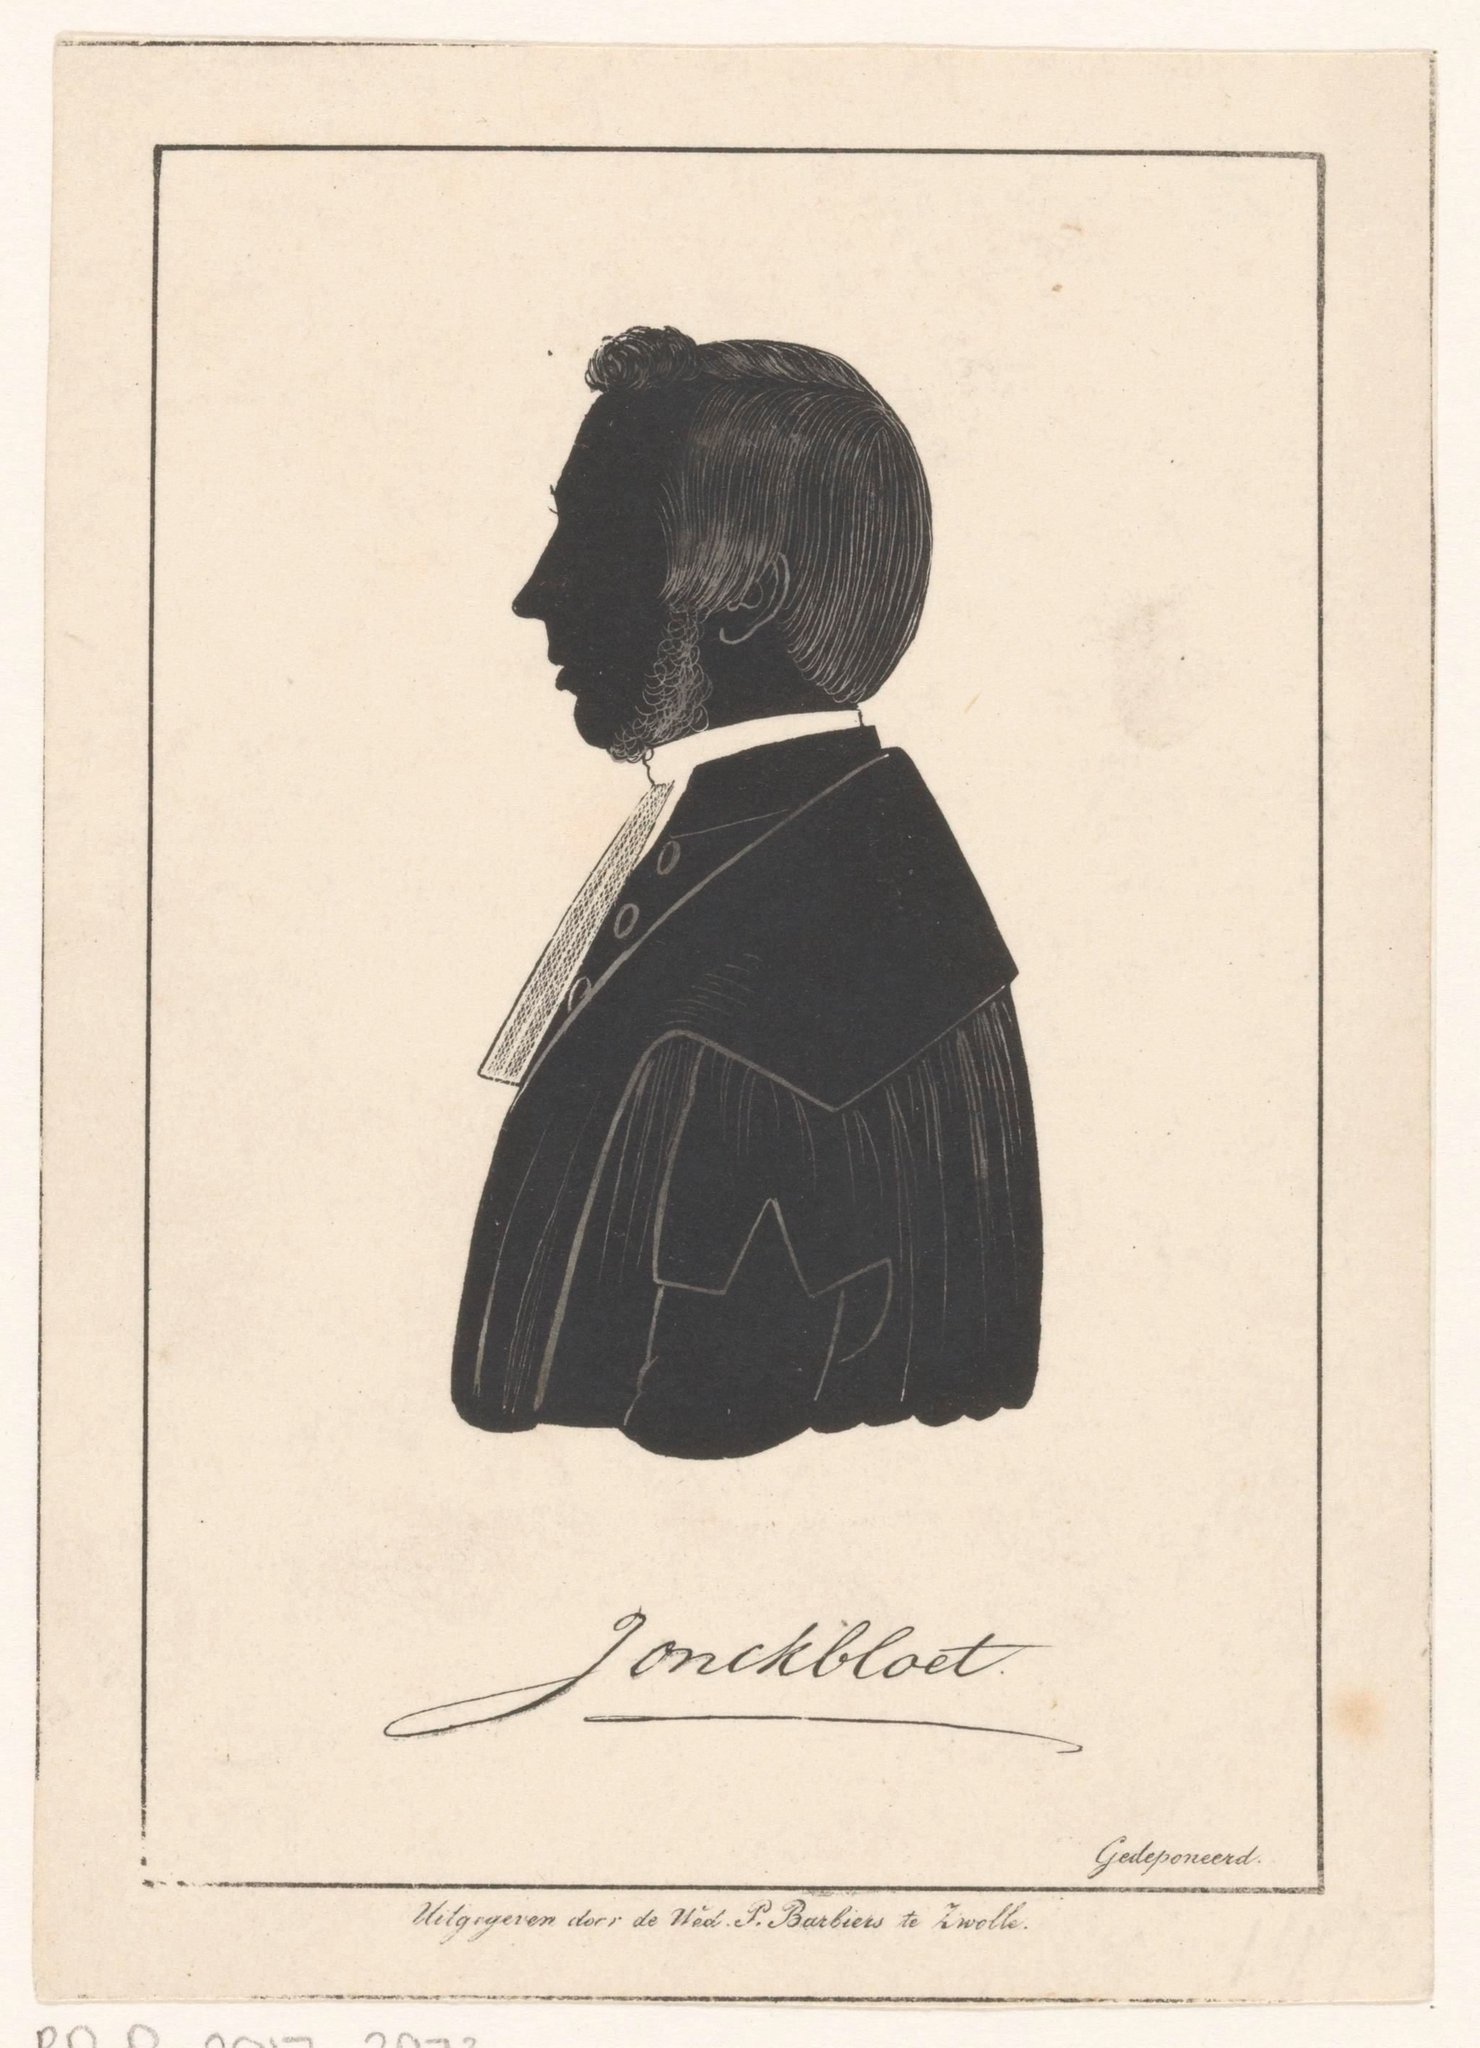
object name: print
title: Silhouetportret van Willem Jozef Andreas Jonckbloet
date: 1848-1862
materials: paper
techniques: hand coloring, lithograph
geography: zwolle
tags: the hague, historical persons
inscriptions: : ‘Gedeponeerd.’, : ‘Gedeponeerd.’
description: Onder het portret de signatuur van de geportretteerde.